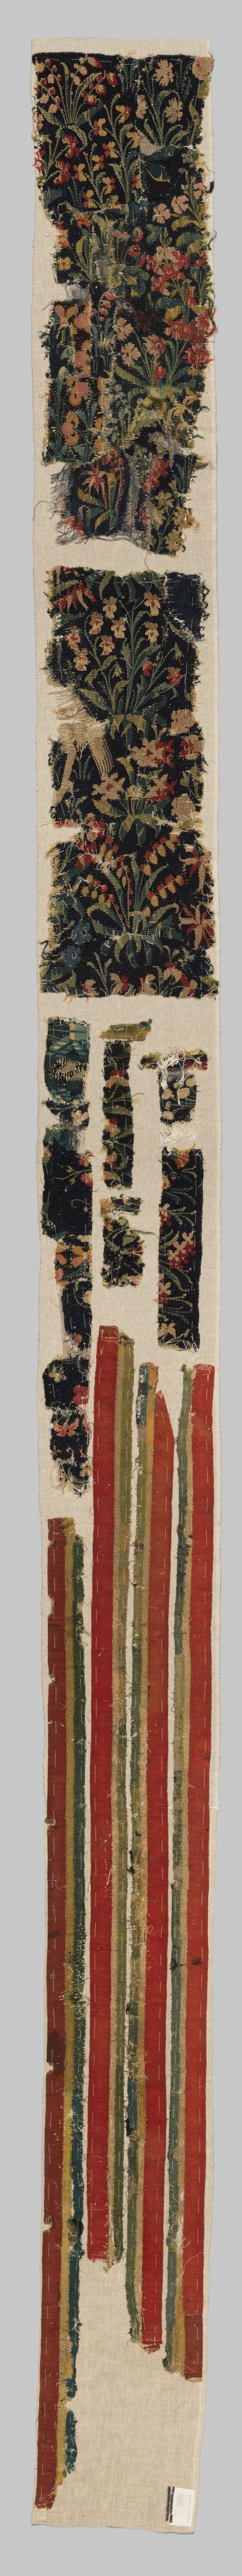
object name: tapestry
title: Millefleurs with Animals (Fragment)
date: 1525-1550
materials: wool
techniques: tapestry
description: Fragment van een mille-fleurs-tapijt. Een blauw-zwart fond is harmonieus bezaaid met in rozetvorm groeiende plantjes met uitwaaierende bloemstengels. Herkenbaar zijn de koekoeksbloem, viooltje, maagdenpalm, madeliefje en verschillende klokjesbloemen. Hiertussen houden zich kleine dieren schuil, als een duif, hoentje, fazant, haan, reiger en half afgesneden, een lynx.